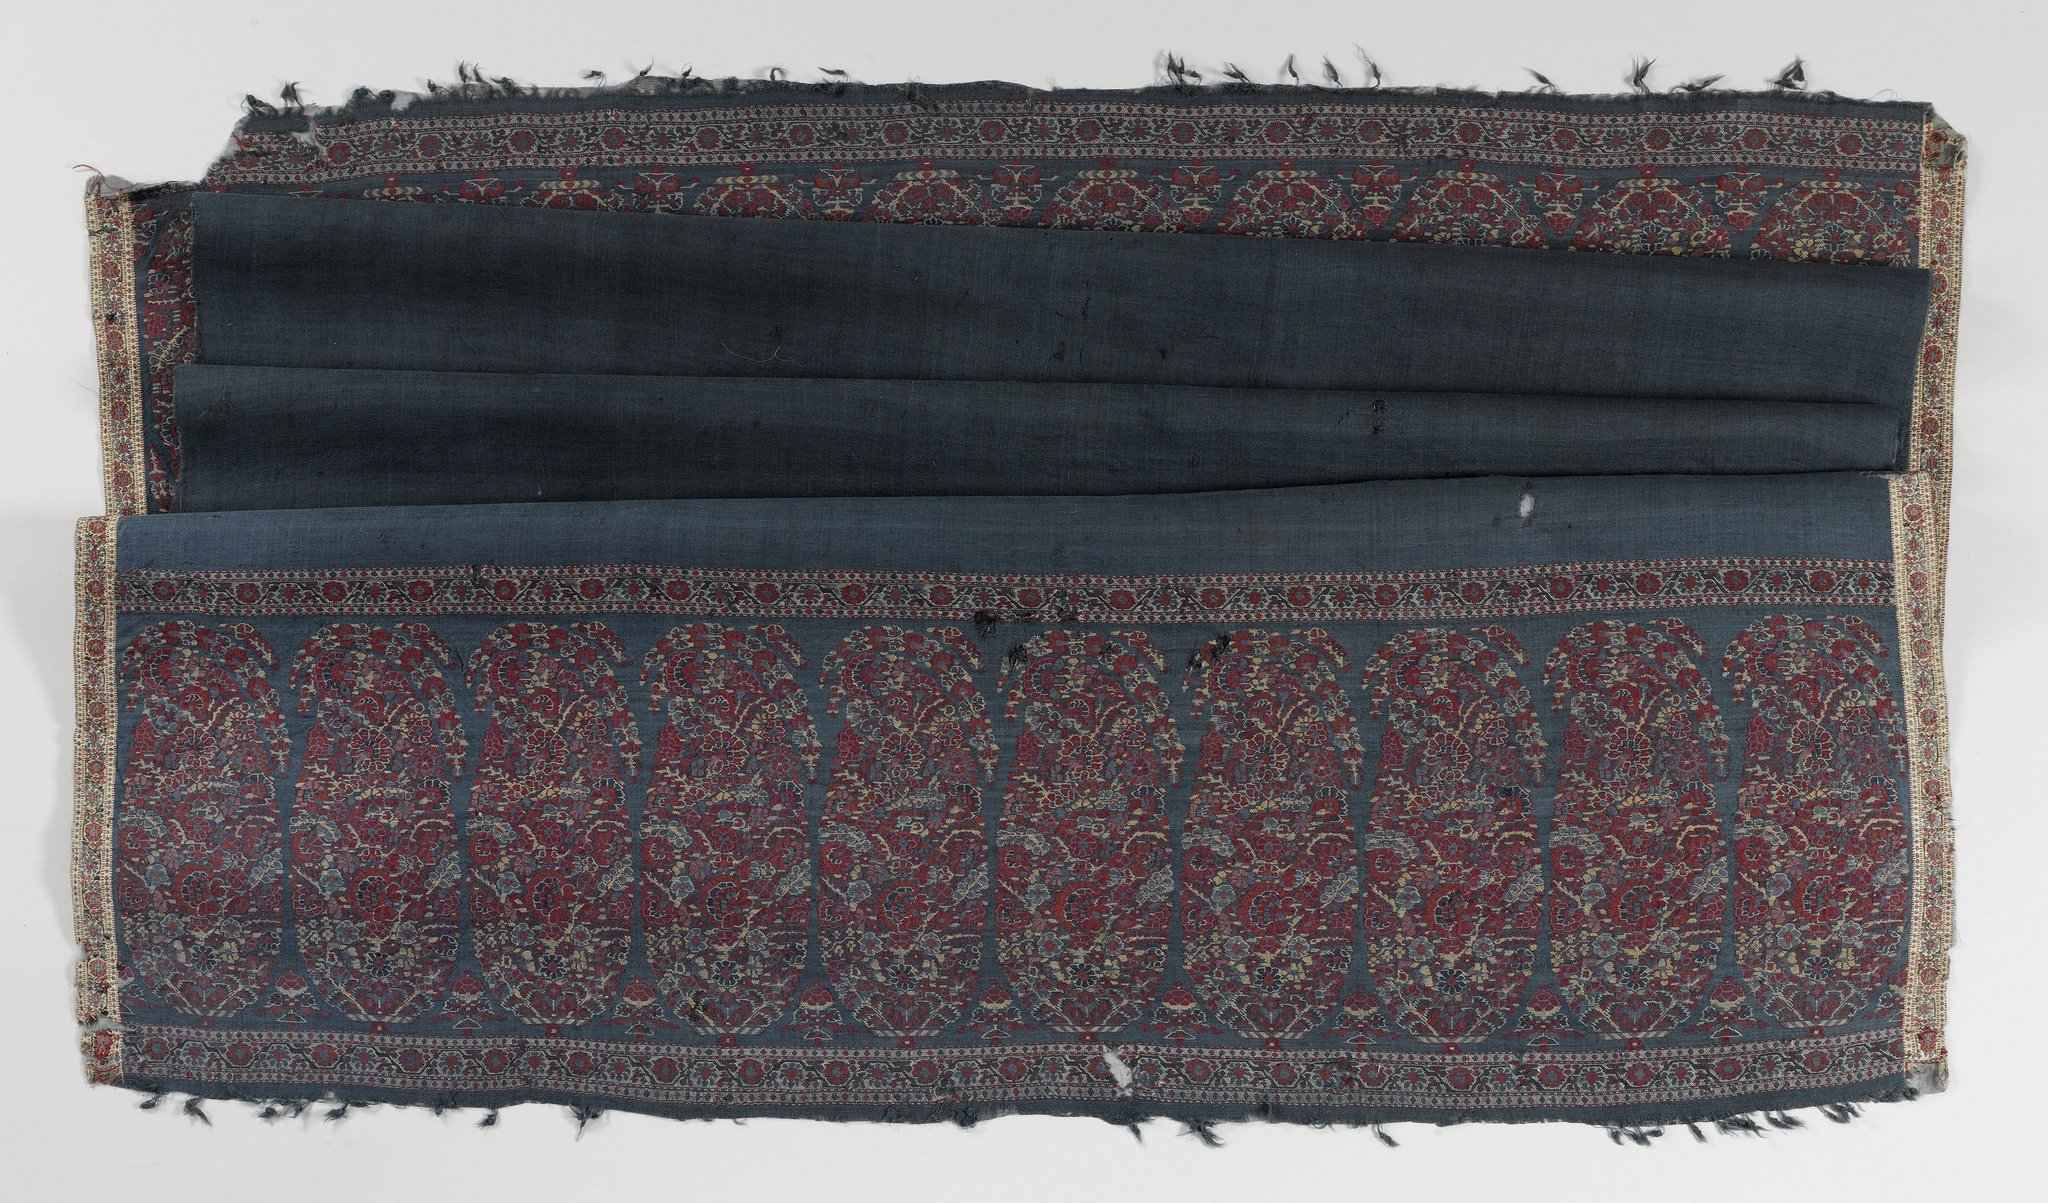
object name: clothing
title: Sjaal van nachtblauwe wol aan beide uiteinden voorzien van een rij veelkleurige palmmotieven en franje van geknoopte kettingdraden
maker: Anonymous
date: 1775-1800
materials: wool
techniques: knotting, weave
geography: kashmir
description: Sjaal van nachtblauwe wol aan beide uiteinden voorzien van een rij veelkleurige palmmotieven en franje van geknoopte kettingdraden. Patroon: een effen nachtblauwe middenstrook vertoont aan de uiteinden een rij van links knikkende palmmotieven staande opeen kleine vlakke schaal op een voet. Zij zijn zonder duidelijke stengels of binnen begrenzing opgebouwd uit kleine bloemen in rood, pioenrood, roze, paars, maisgeel, groen en wit. De grootste twee bloemen zijn waaiervormig en staan in het midden en in de top. Voorts o.a. aarvormige bloempjes. Tussenvulling alleen naast de voet en bij de top; de laatste bestaat uit een lange en een korte sikkelvormige bloemstengel. Twee smalle dwarslijsten van wit vertonen een lopende rank met rozetbloempjes. Twee identieke lengtelijsten vertonen helderder witte grond, omdat hier de kettingdraden ook van wit zijn genomen. Geknoopte franje van de kettingdraden. Techniek: weefbinding van keper, 2x2.